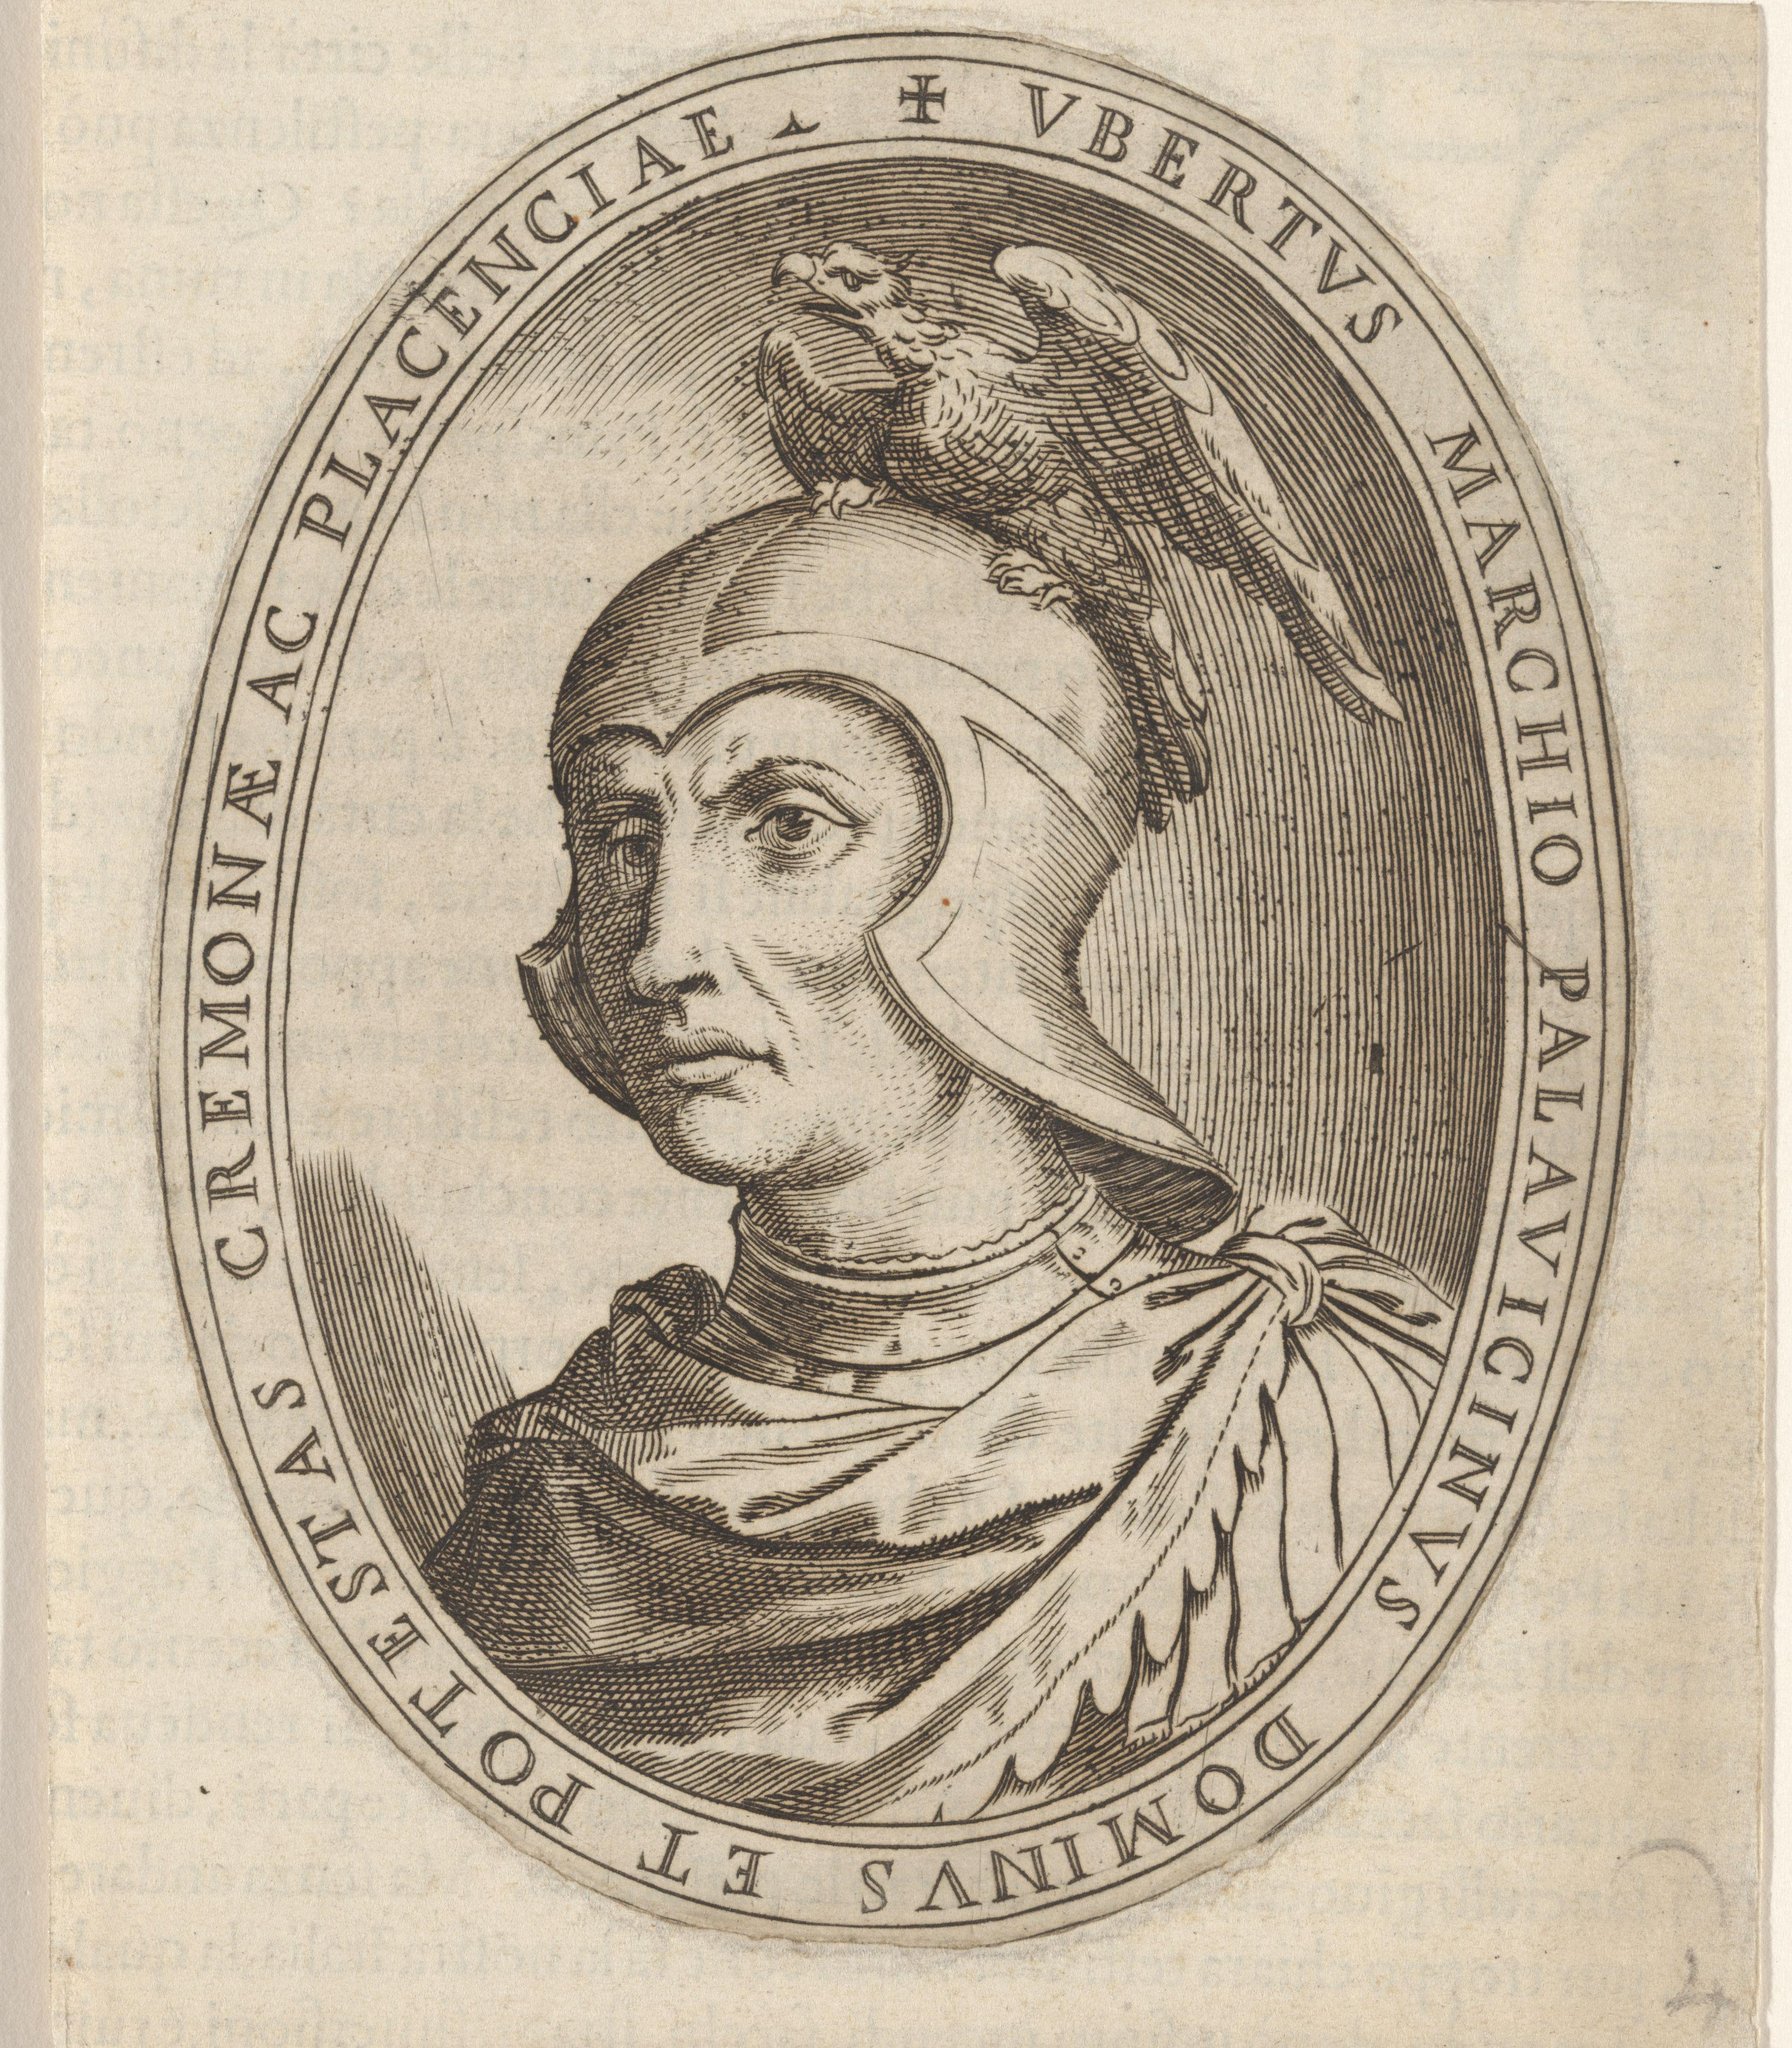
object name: print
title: Portret van Umberto V Palavicino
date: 1585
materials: paper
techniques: engraving, letterpress printing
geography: cremona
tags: historical persons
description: Prent uit Antonio Campo, Cremona fedelissima citta, et nobilissima colonia de Romani rappresentata in disegno col suo contado; et illustrata d'una breve historia, Milaan: Filippo Ghisolfi 1642, vol. 3, p. 46.